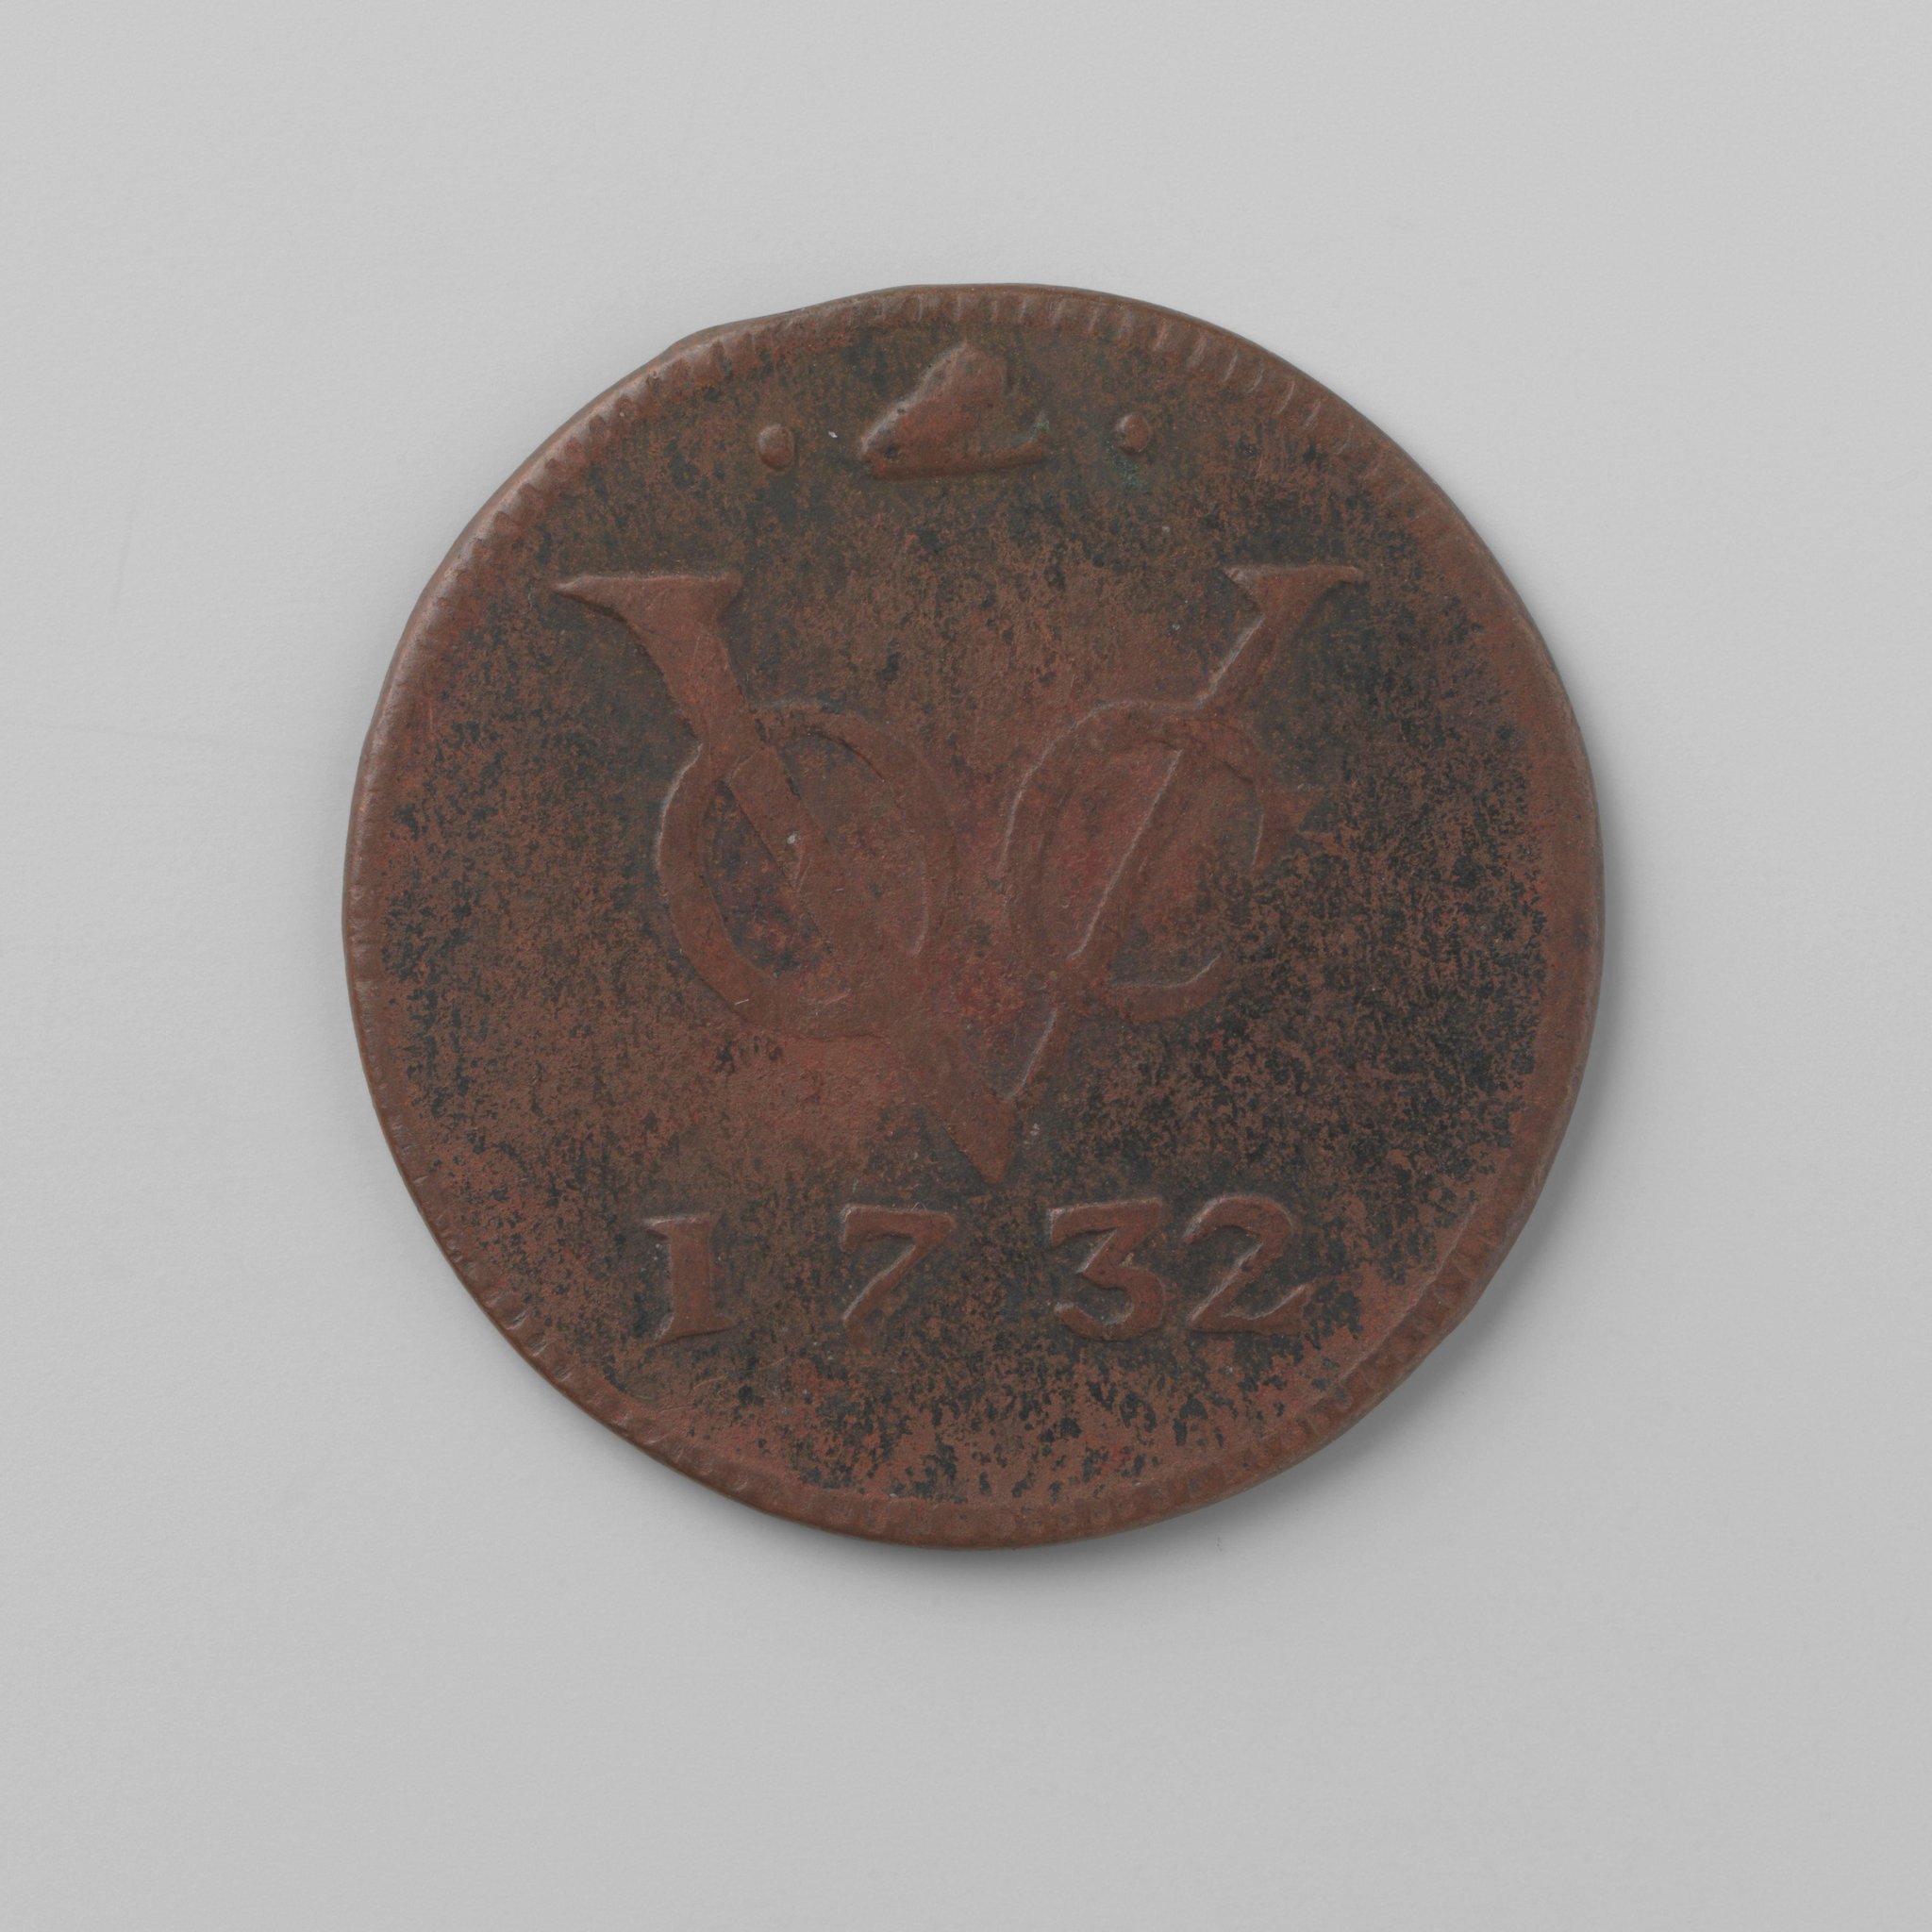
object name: coin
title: Duit van de VOC uit Gelderland,1732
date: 1732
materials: copper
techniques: striking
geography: harderwijk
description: Koperen munt. Voorzijde: tussen wapenspreuk gekroond wapenschild van Gelderland. Keerzijde: monogram van de VOC, waarboven muntmeesterteken en waaronder jaartal. Gladde rand.